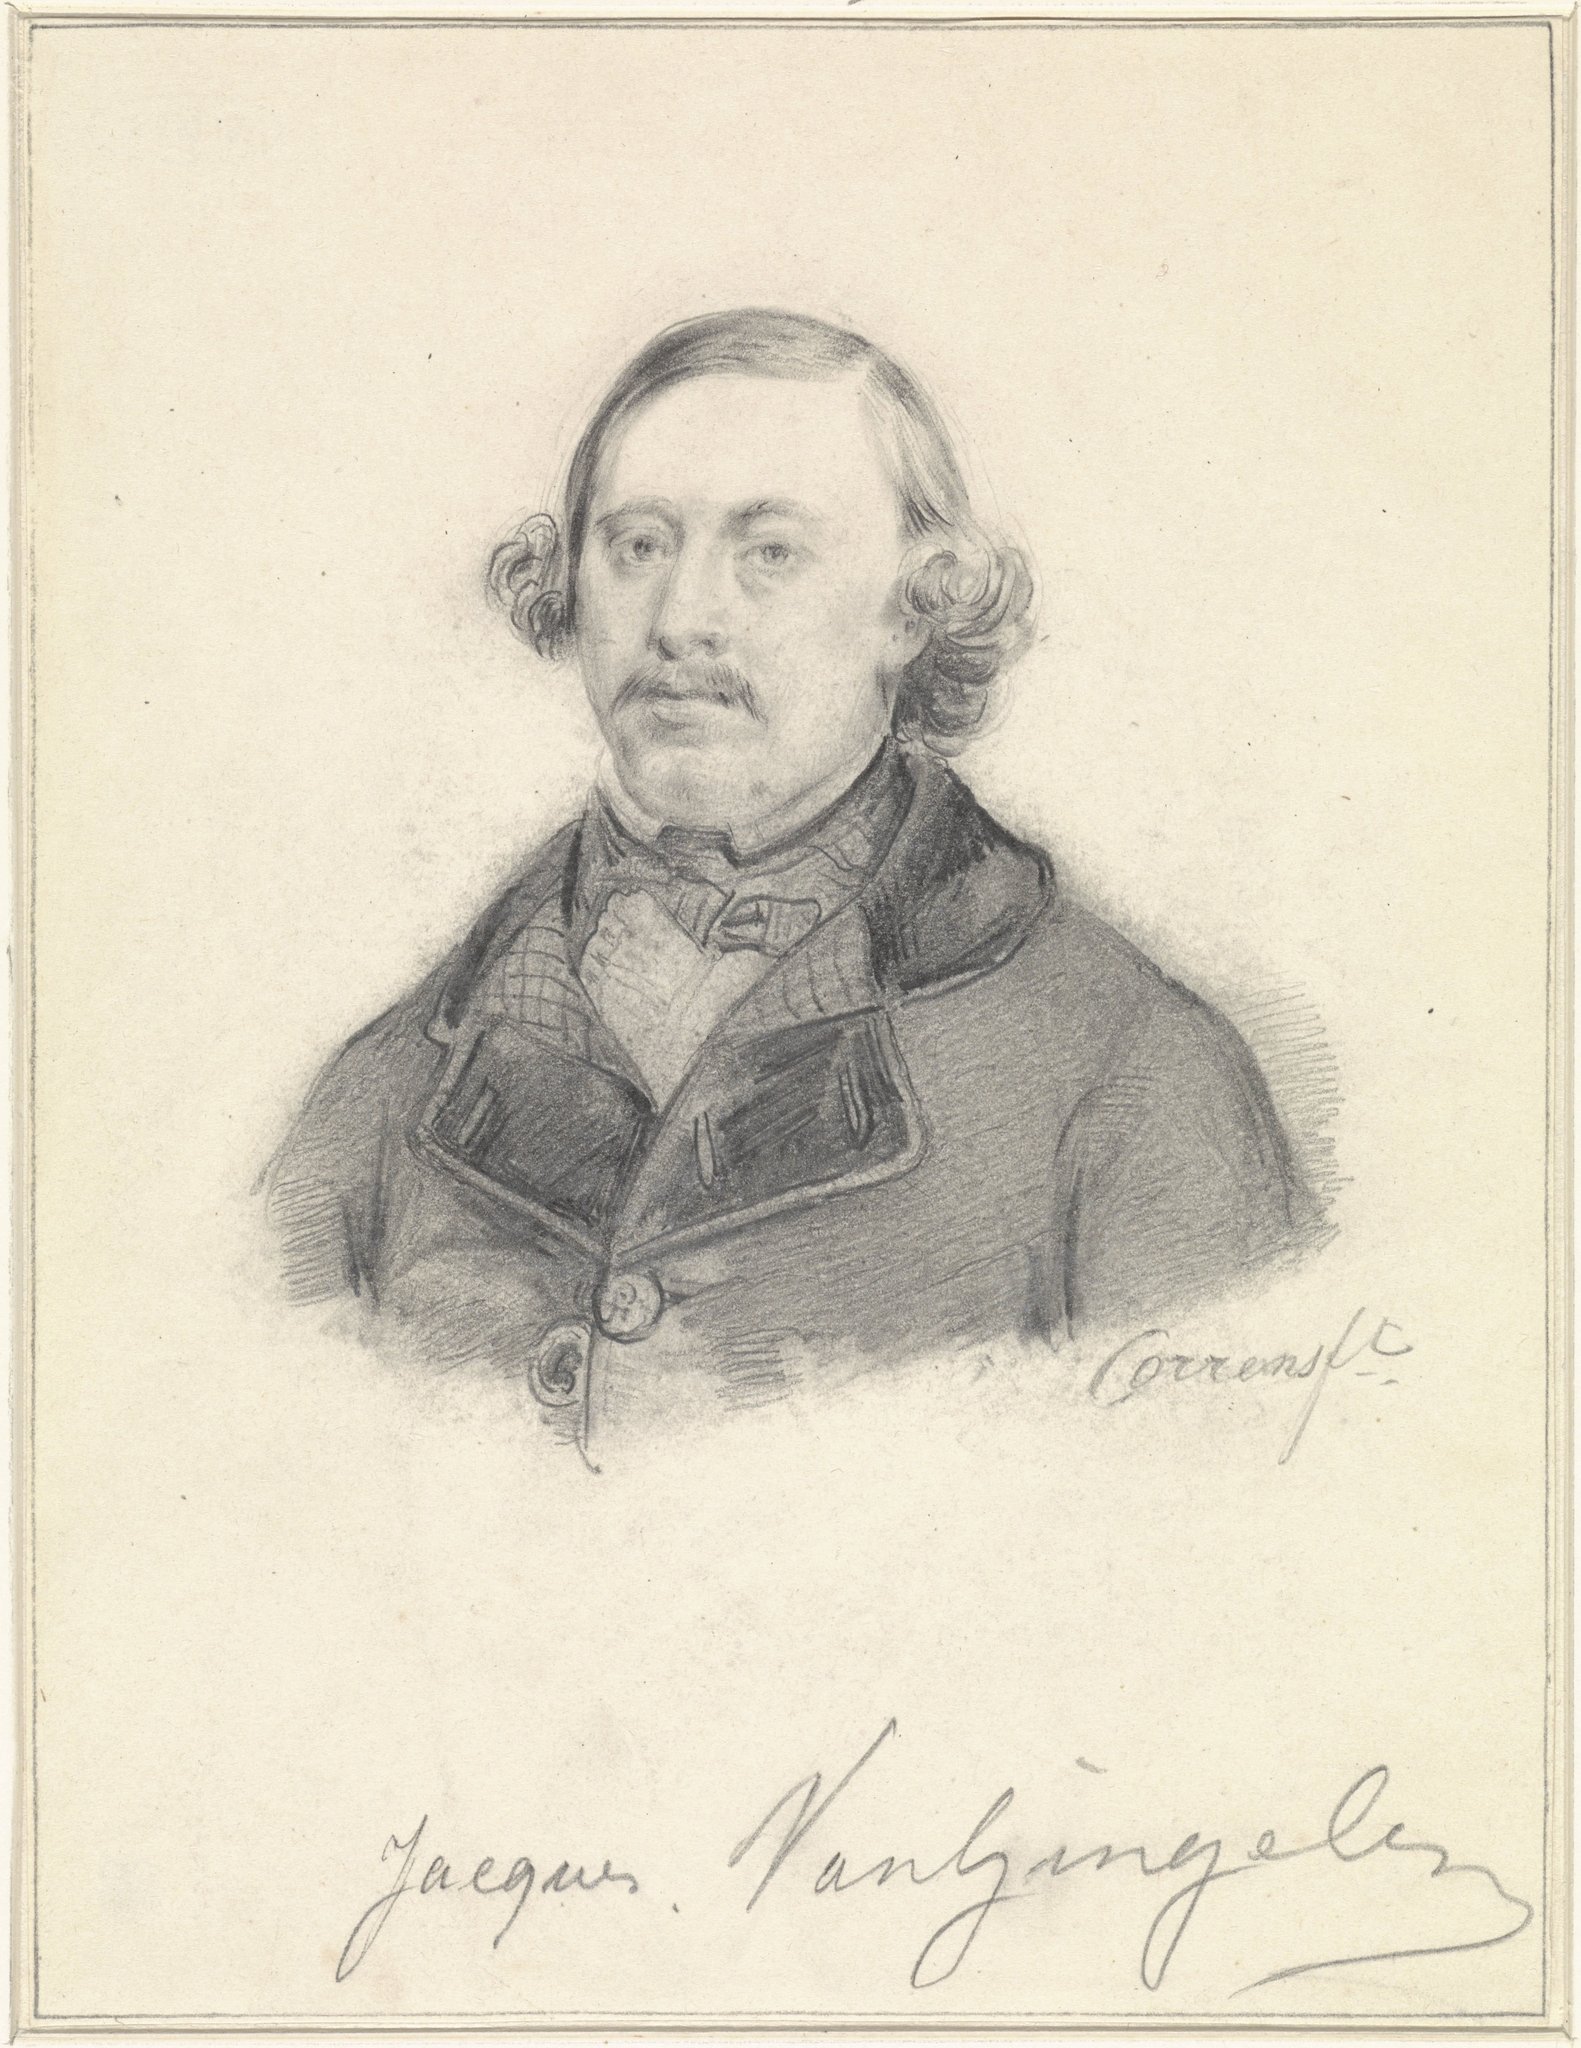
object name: design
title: Portret van Jacques Van Gingelen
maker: jozef cornelius correns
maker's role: draughtsman, painter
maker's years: 1814-1907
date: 1840-1842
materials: paper, pencil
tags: print maker, jacques van gingelen, historical persons, portrait, self-portrait of painter, portrait, self-portrait of artist, portrait, self-portrait of draughtsman